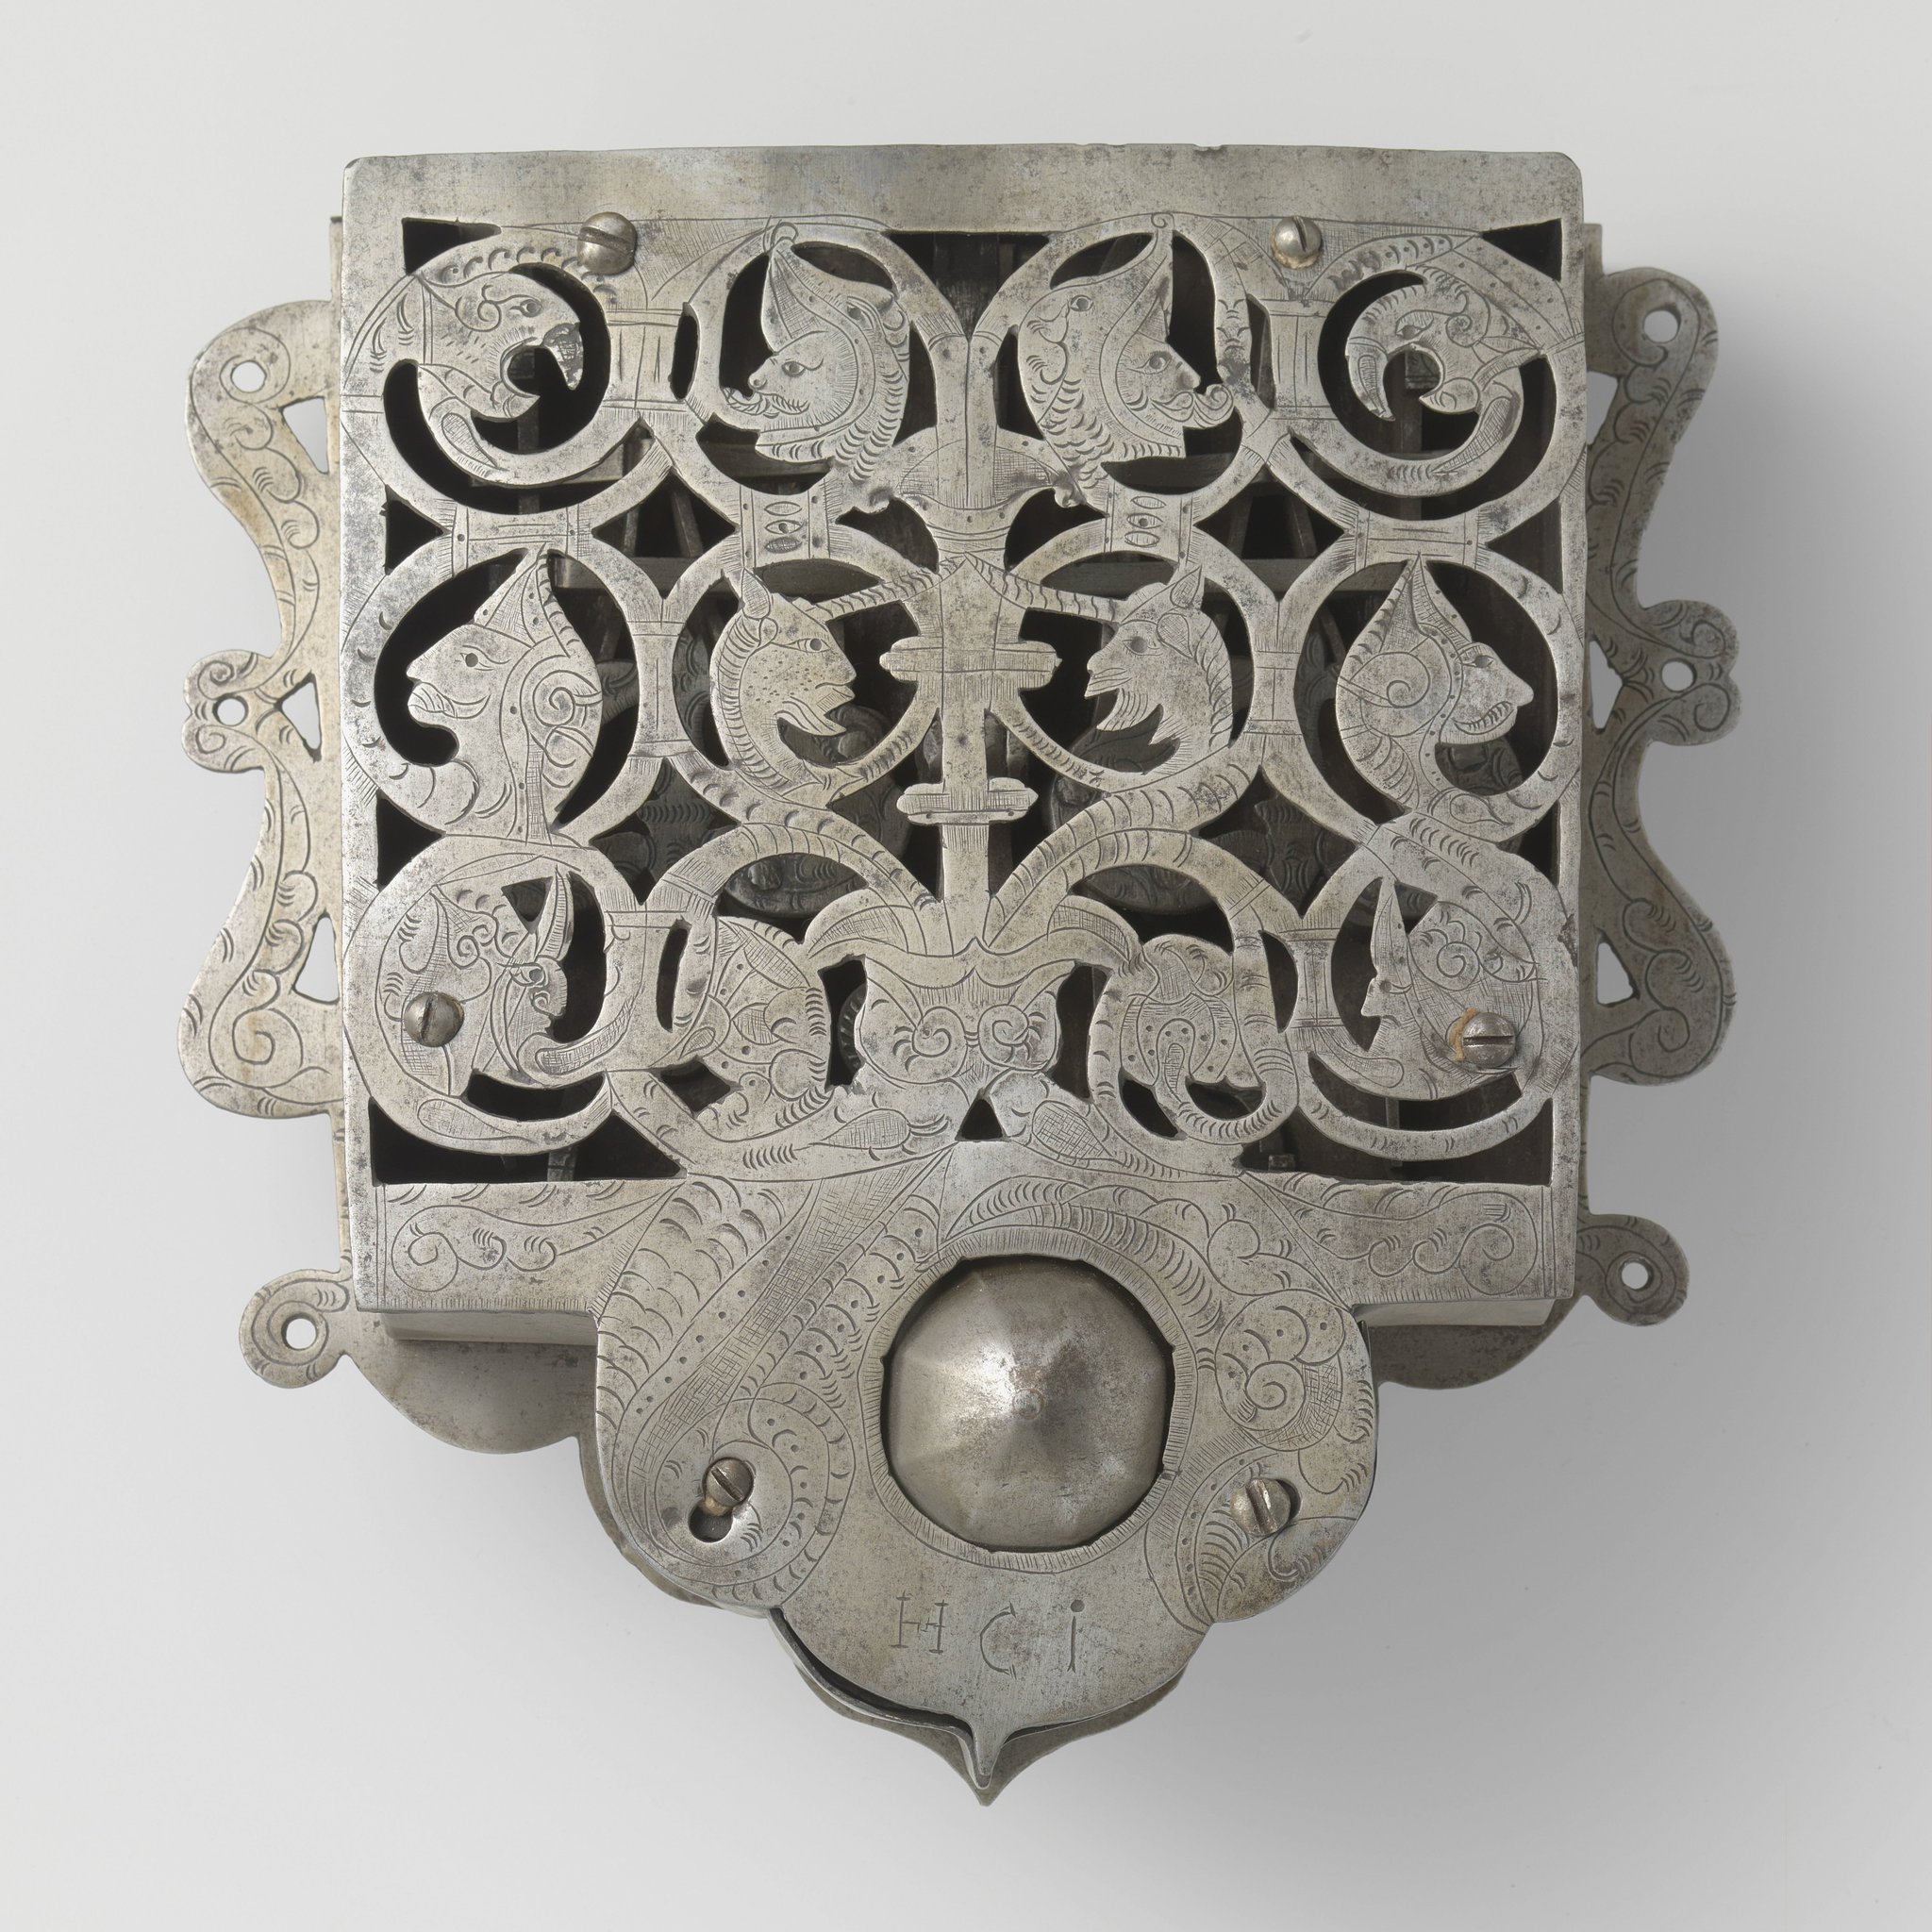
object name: lock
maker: Anonymous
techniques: engraving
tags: anthropomorphic ornament